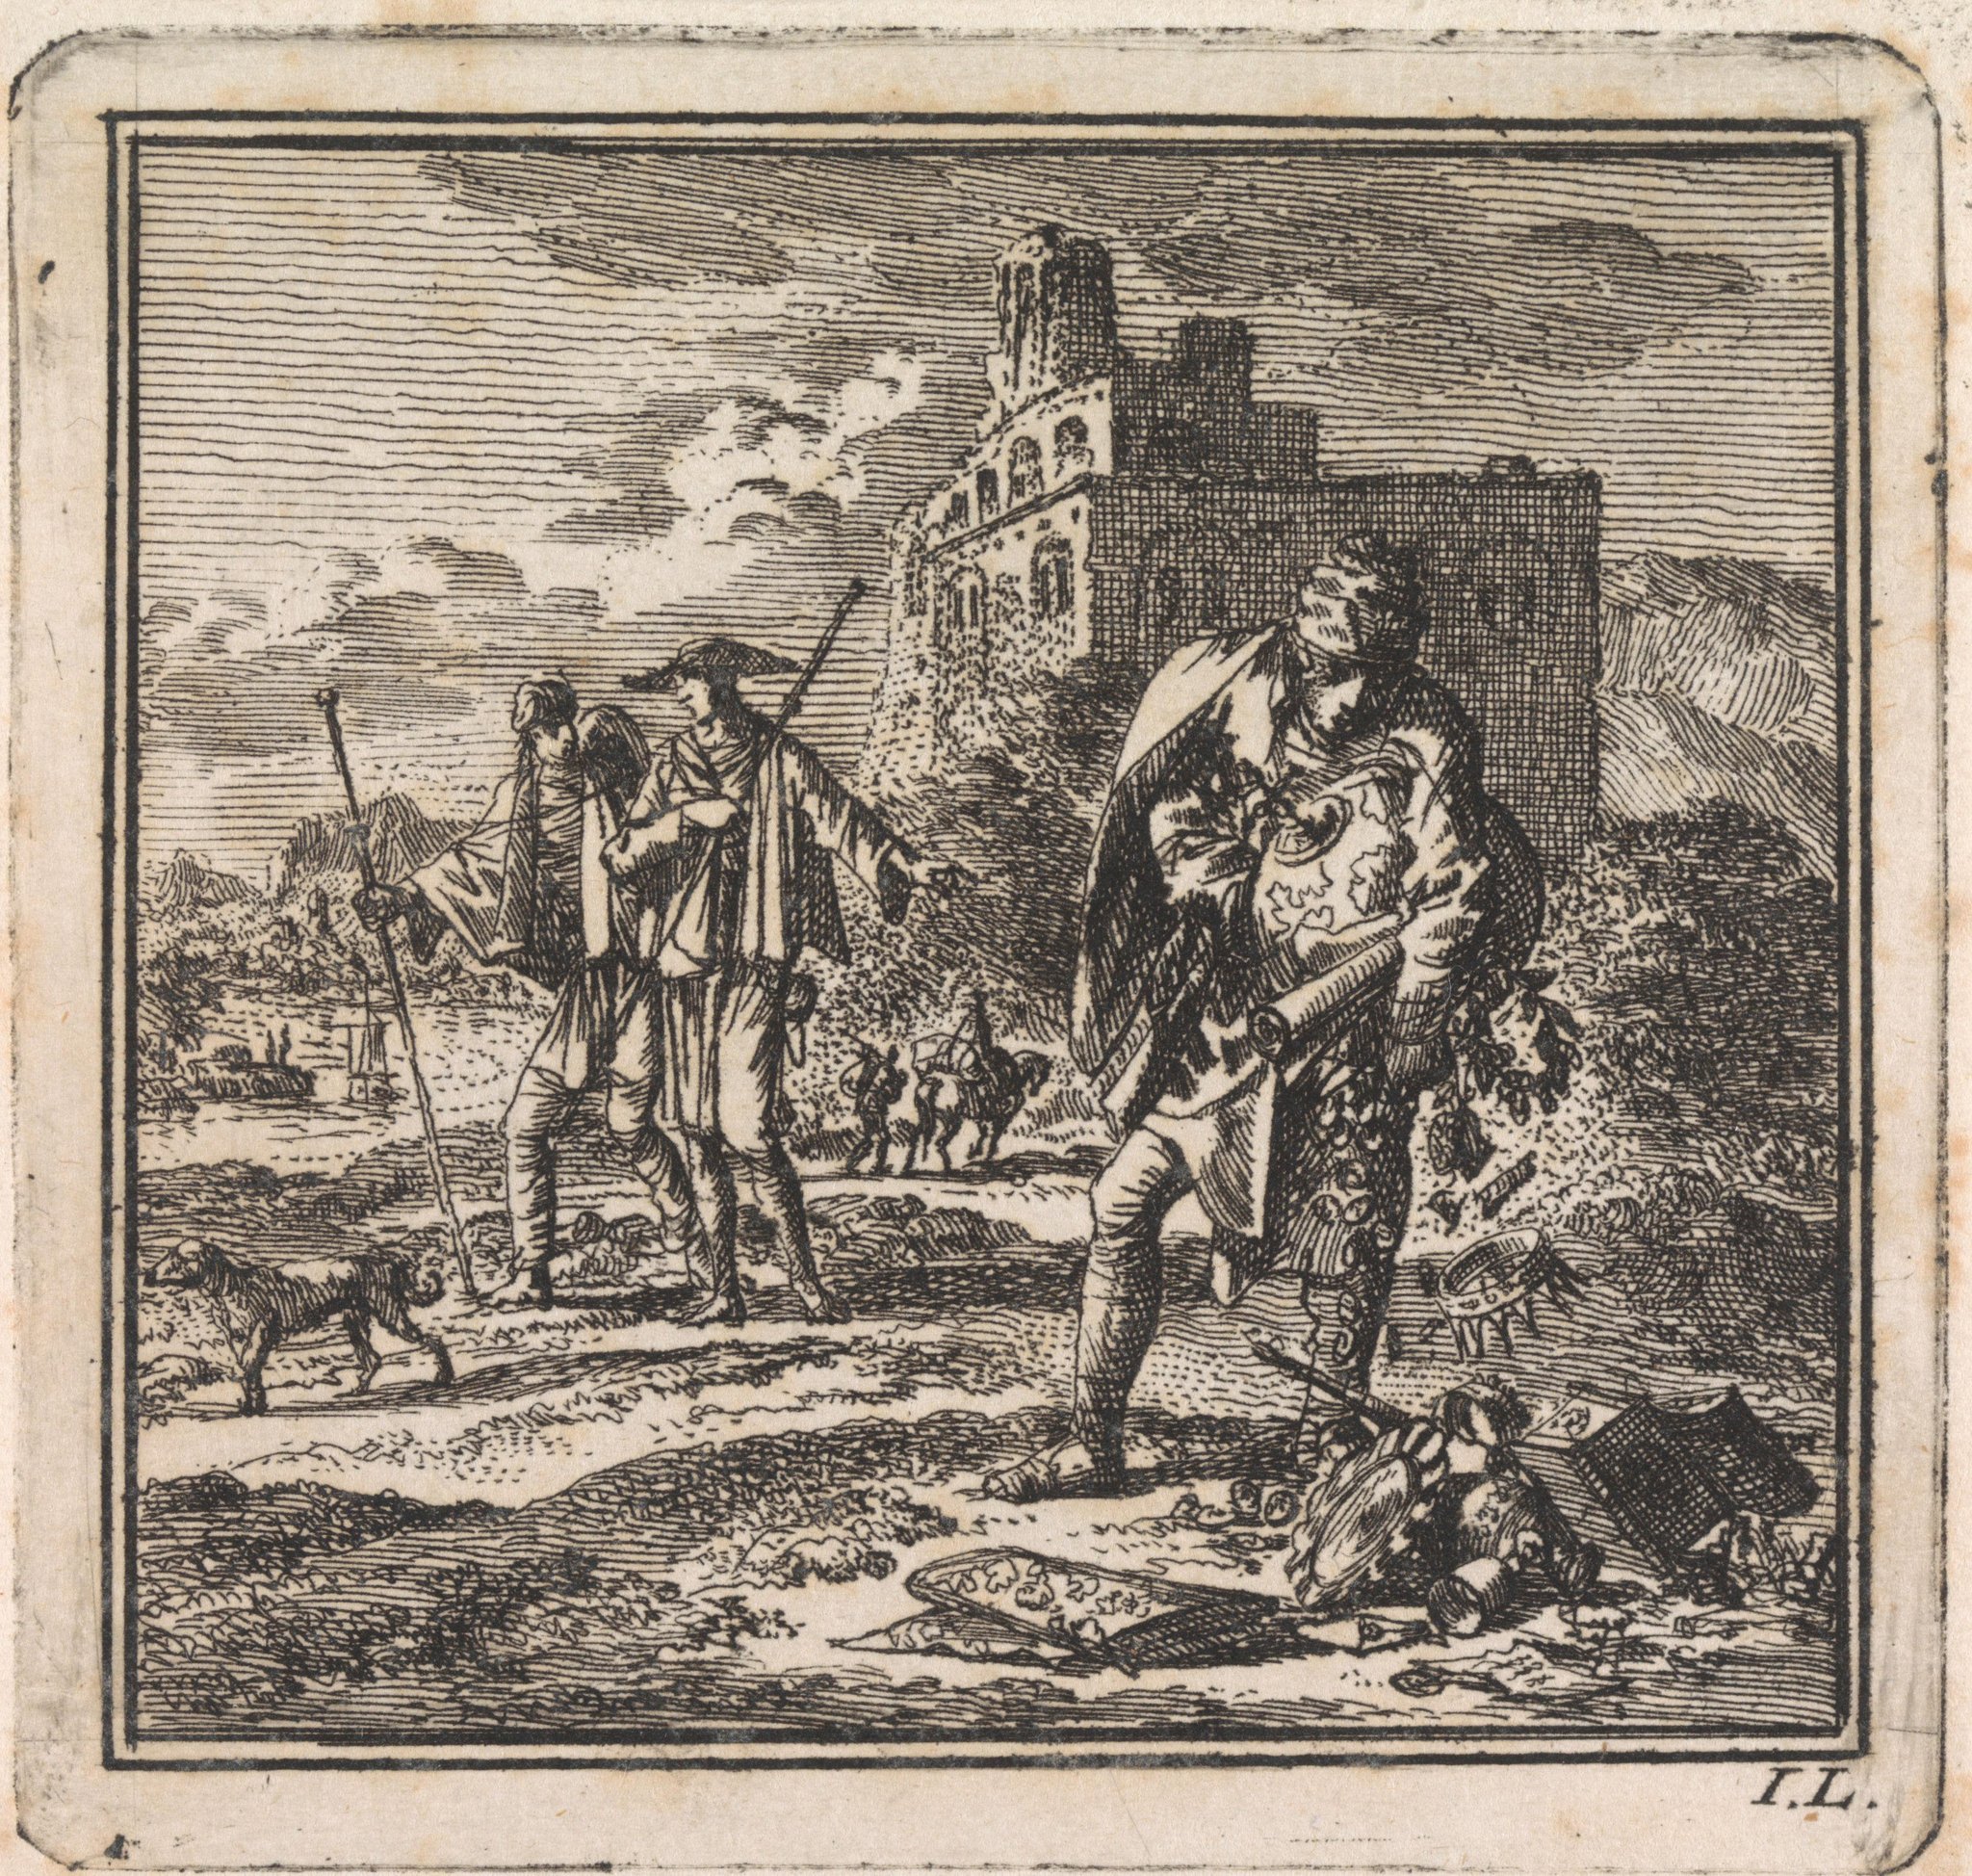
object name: print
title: De Onwisse Veelheid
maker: jan luyken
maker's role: draughtsman, print maker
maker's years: 1649-1712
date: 1710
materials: paper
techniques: etching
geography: amsterdam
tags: earth, world as celestial body, falling, exhibition of wealth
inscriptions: collector's mark: Lugt 2228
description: Illustratie uit: Luyken, Jan. De onwaardige wereld, vertoond in vyftig zinnebeelden, met godlyke spreuken en stichtelyke verzen. Amsterdam: Pieter Arentsz. II (wed.) en Cornelis van der Sys, 1710, p. 156.